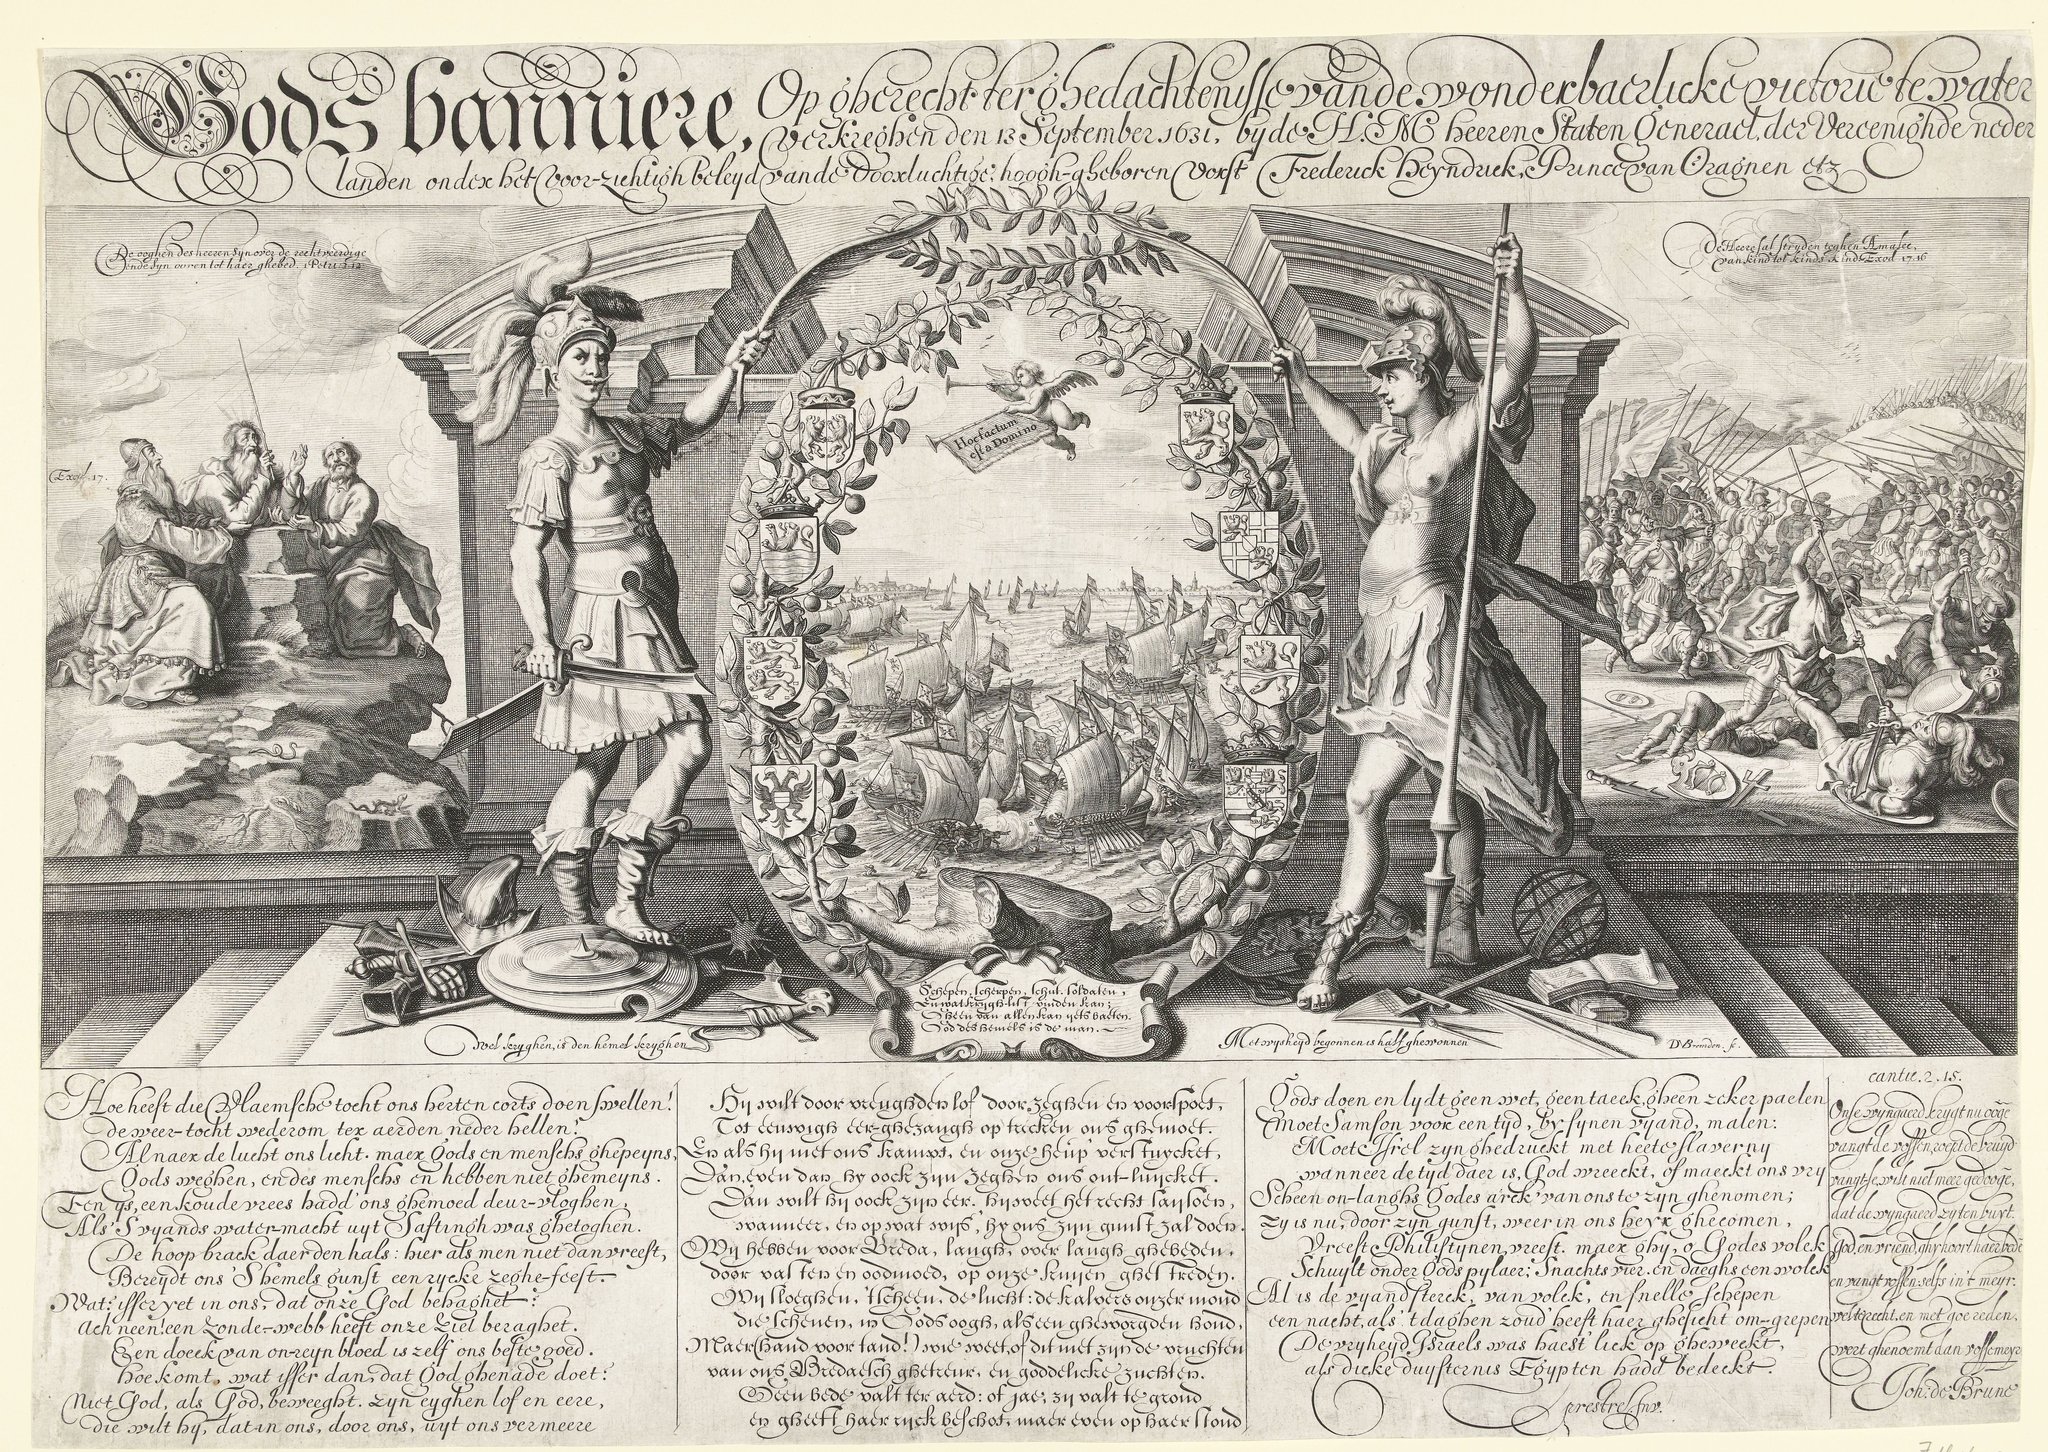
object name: propagandaprent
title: Gods banniere, Op gherecht ter ghedachtenisse van de wonderbaerlicke victorie te water verkreghen den 13 September 1631, by de H.M. heeren Staten Generael, der Vereenighde nederlanden onder het voor-zichtigh beleyd van de doorluchtige, hoogh-gheboren vorst Frederick Heyndrick, Prince van Oragnen etc.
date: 1631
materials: paper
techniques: engraving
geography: northern netherlands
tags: moses sitting on a rock, arms held up by aaron and hur; the amalekites are defeated, battle (+ naval force)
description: Allegorie op de overwinning op het Slaak, zeeslag tussen Staatse en Spaanse vloten, 12-13 september 1631. Centraal een voorstelling van de zeeslag omkranst met oranjetakken en de wapens van Frederik Hendrik en de zeven provincies, geflankeerd door Mars en Minerva met palmtakken en lauwerkrans van de overwinning. Links Aäron en Chur die de armen en staf van Mozes ondersteunen tijdens het bidden op de rots waardoor de Israëlieten onder Jozua de Amalekieten kunnen verslaan (rechts). In het onderschrift 4 kolommen met gekalligrafeerde tekst.